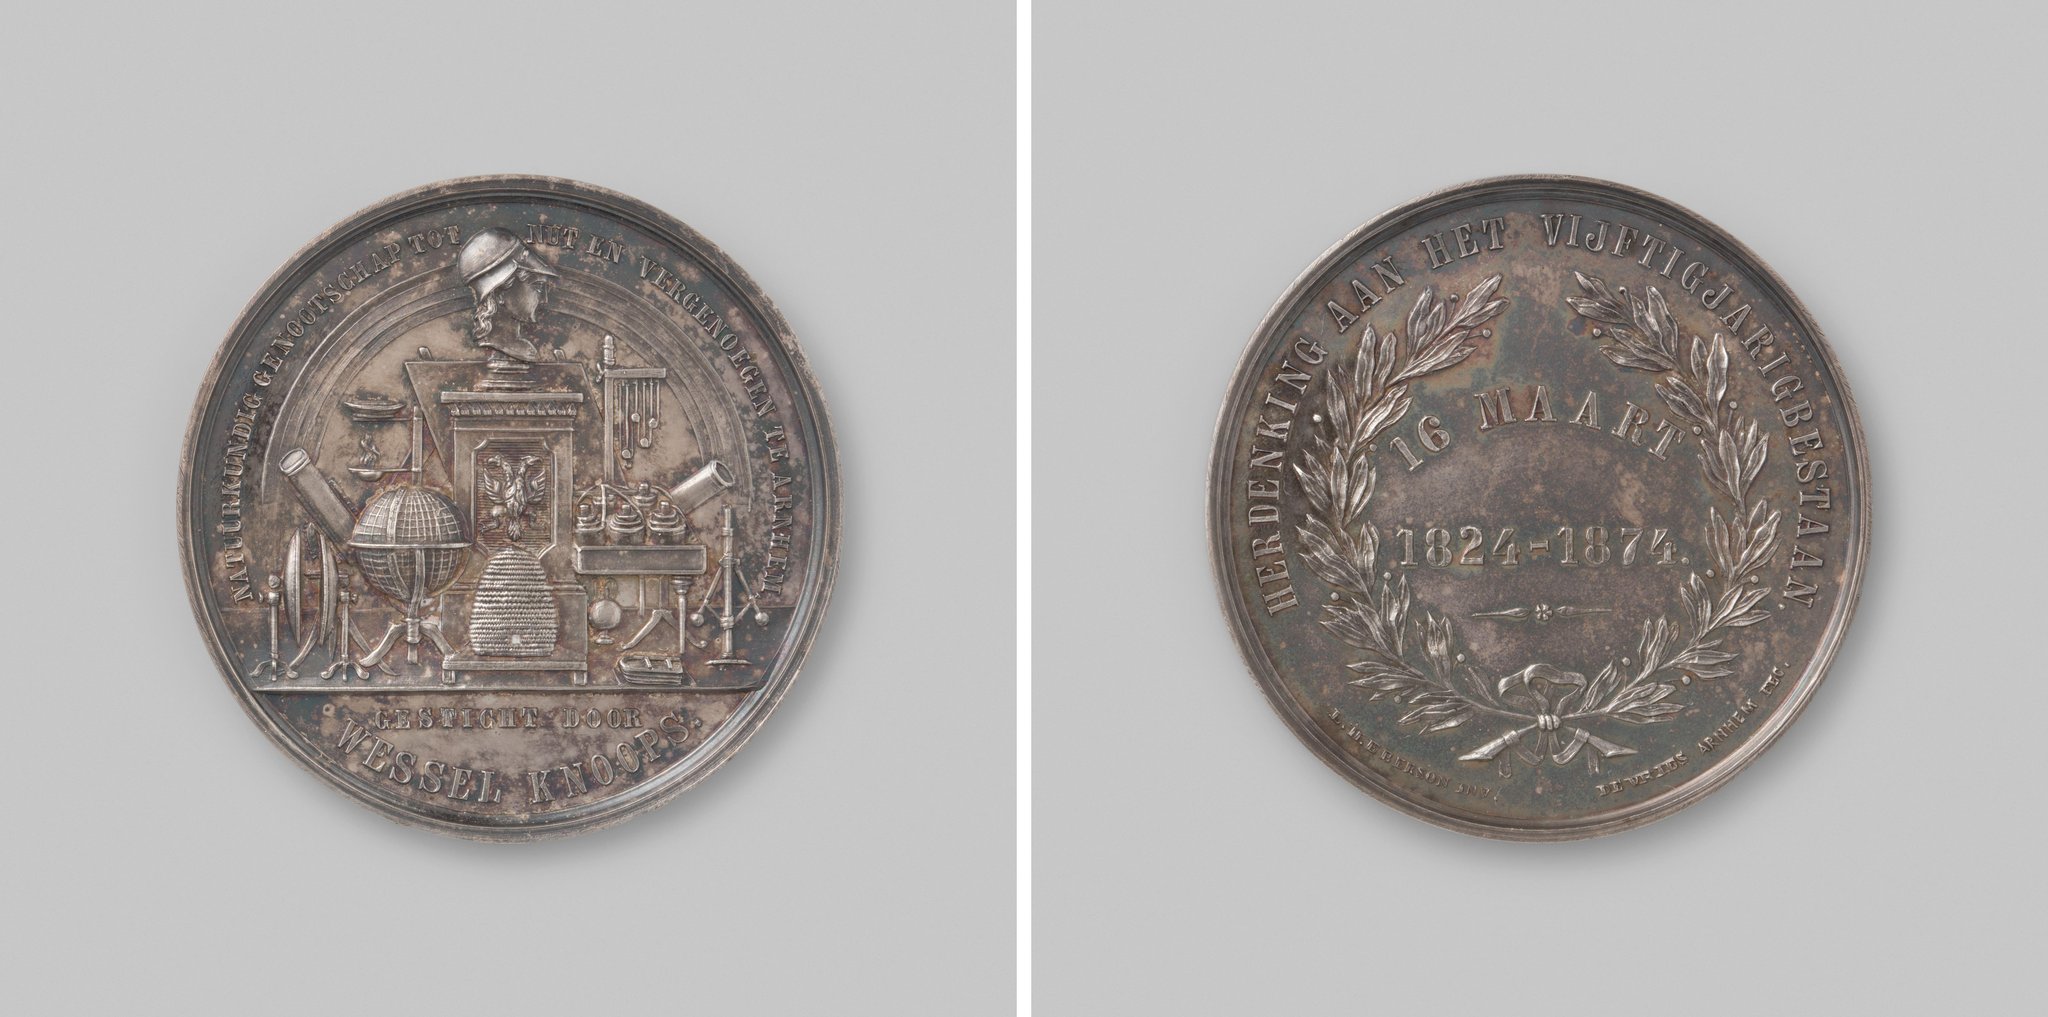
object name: history medal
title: Vijftigjarig bestaan van het Natuurkundig Genootschap tot Nut en Vergenoegen te Arnhem, gesticht door Wessel Knoops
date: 1874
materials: silver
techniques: striking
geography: arnhem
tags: arnhem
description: Zilveren penning. Voorzijde: wetenschappelijke instrumenten, waaronder telescoop en globe, verzameld rond gehelmde buste op sokkel, die wapen draagt binnen omschrift; afsnede: opschrift. Keerzijde: datering binnen lauwerkrans en omschrift.